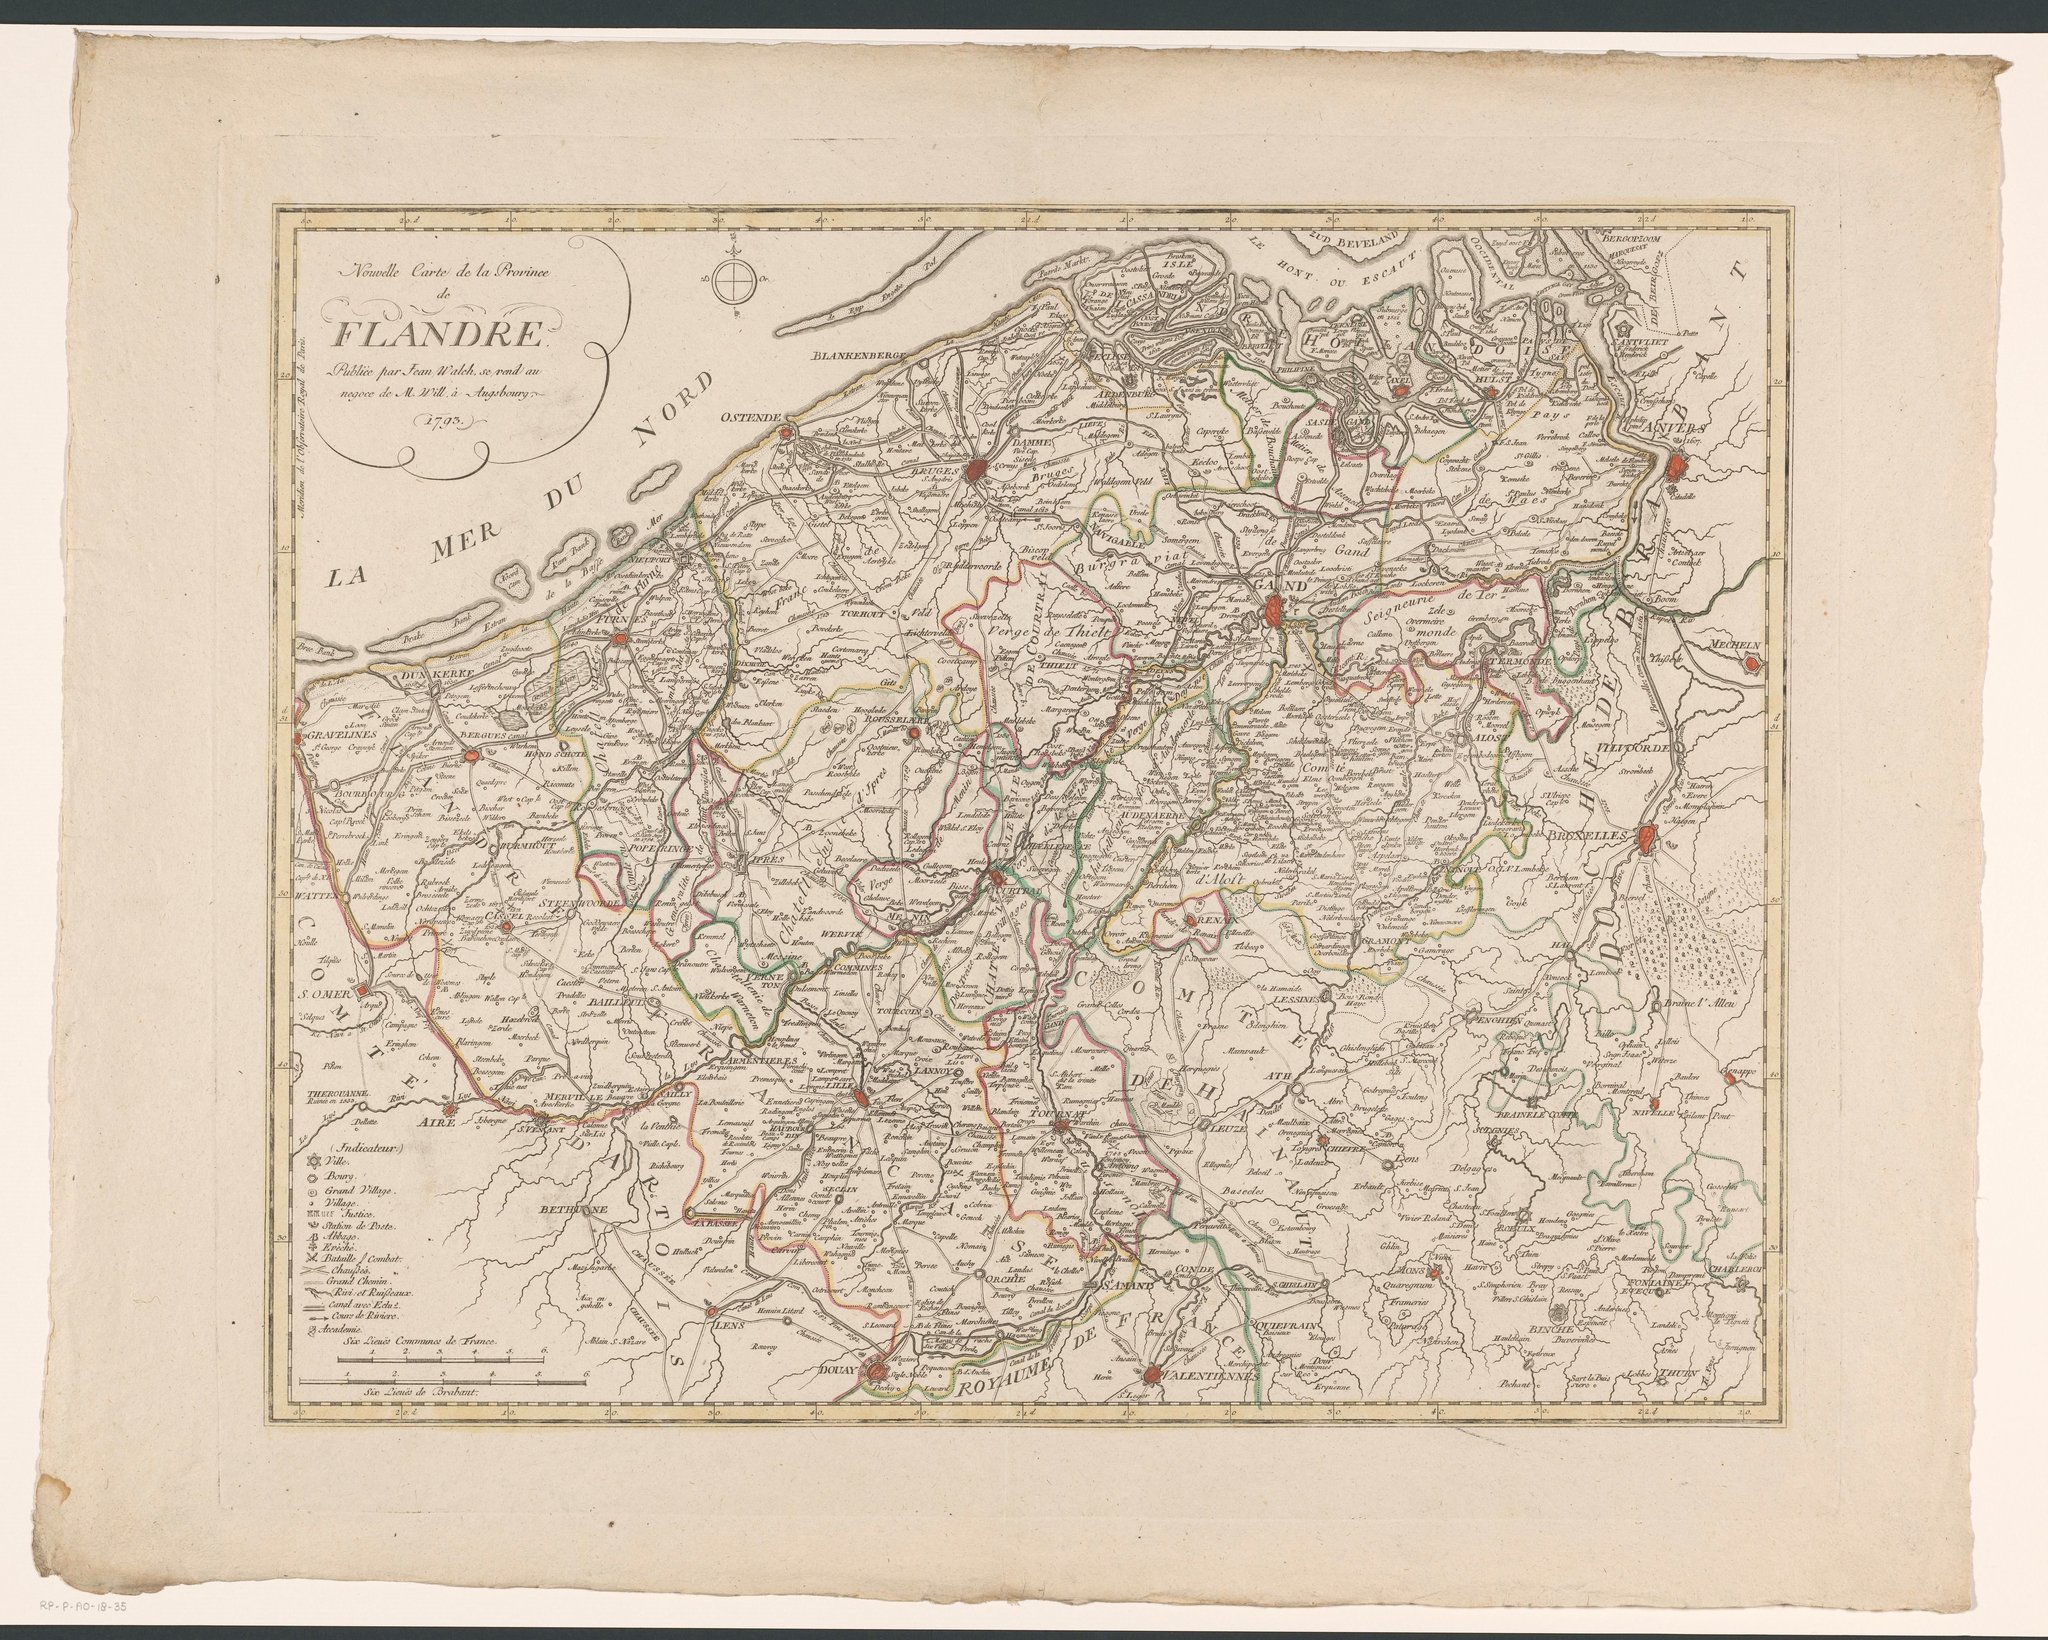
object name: print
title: Kaart van het graafschap Vlaanderen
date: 1793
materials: paper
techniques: engraving, etching, hand coloring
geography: augsburg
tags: maps of separate countries or regions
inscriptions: date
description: Kaart van het graafschap Vlaanderen. Linksboven de titel. Linksonder een legenda en twee schaalstokken: Six Lieuës Communes de France / Six Lieuës de Brabant. De kaart is voorzien van een gradenverdeling langs de randen.